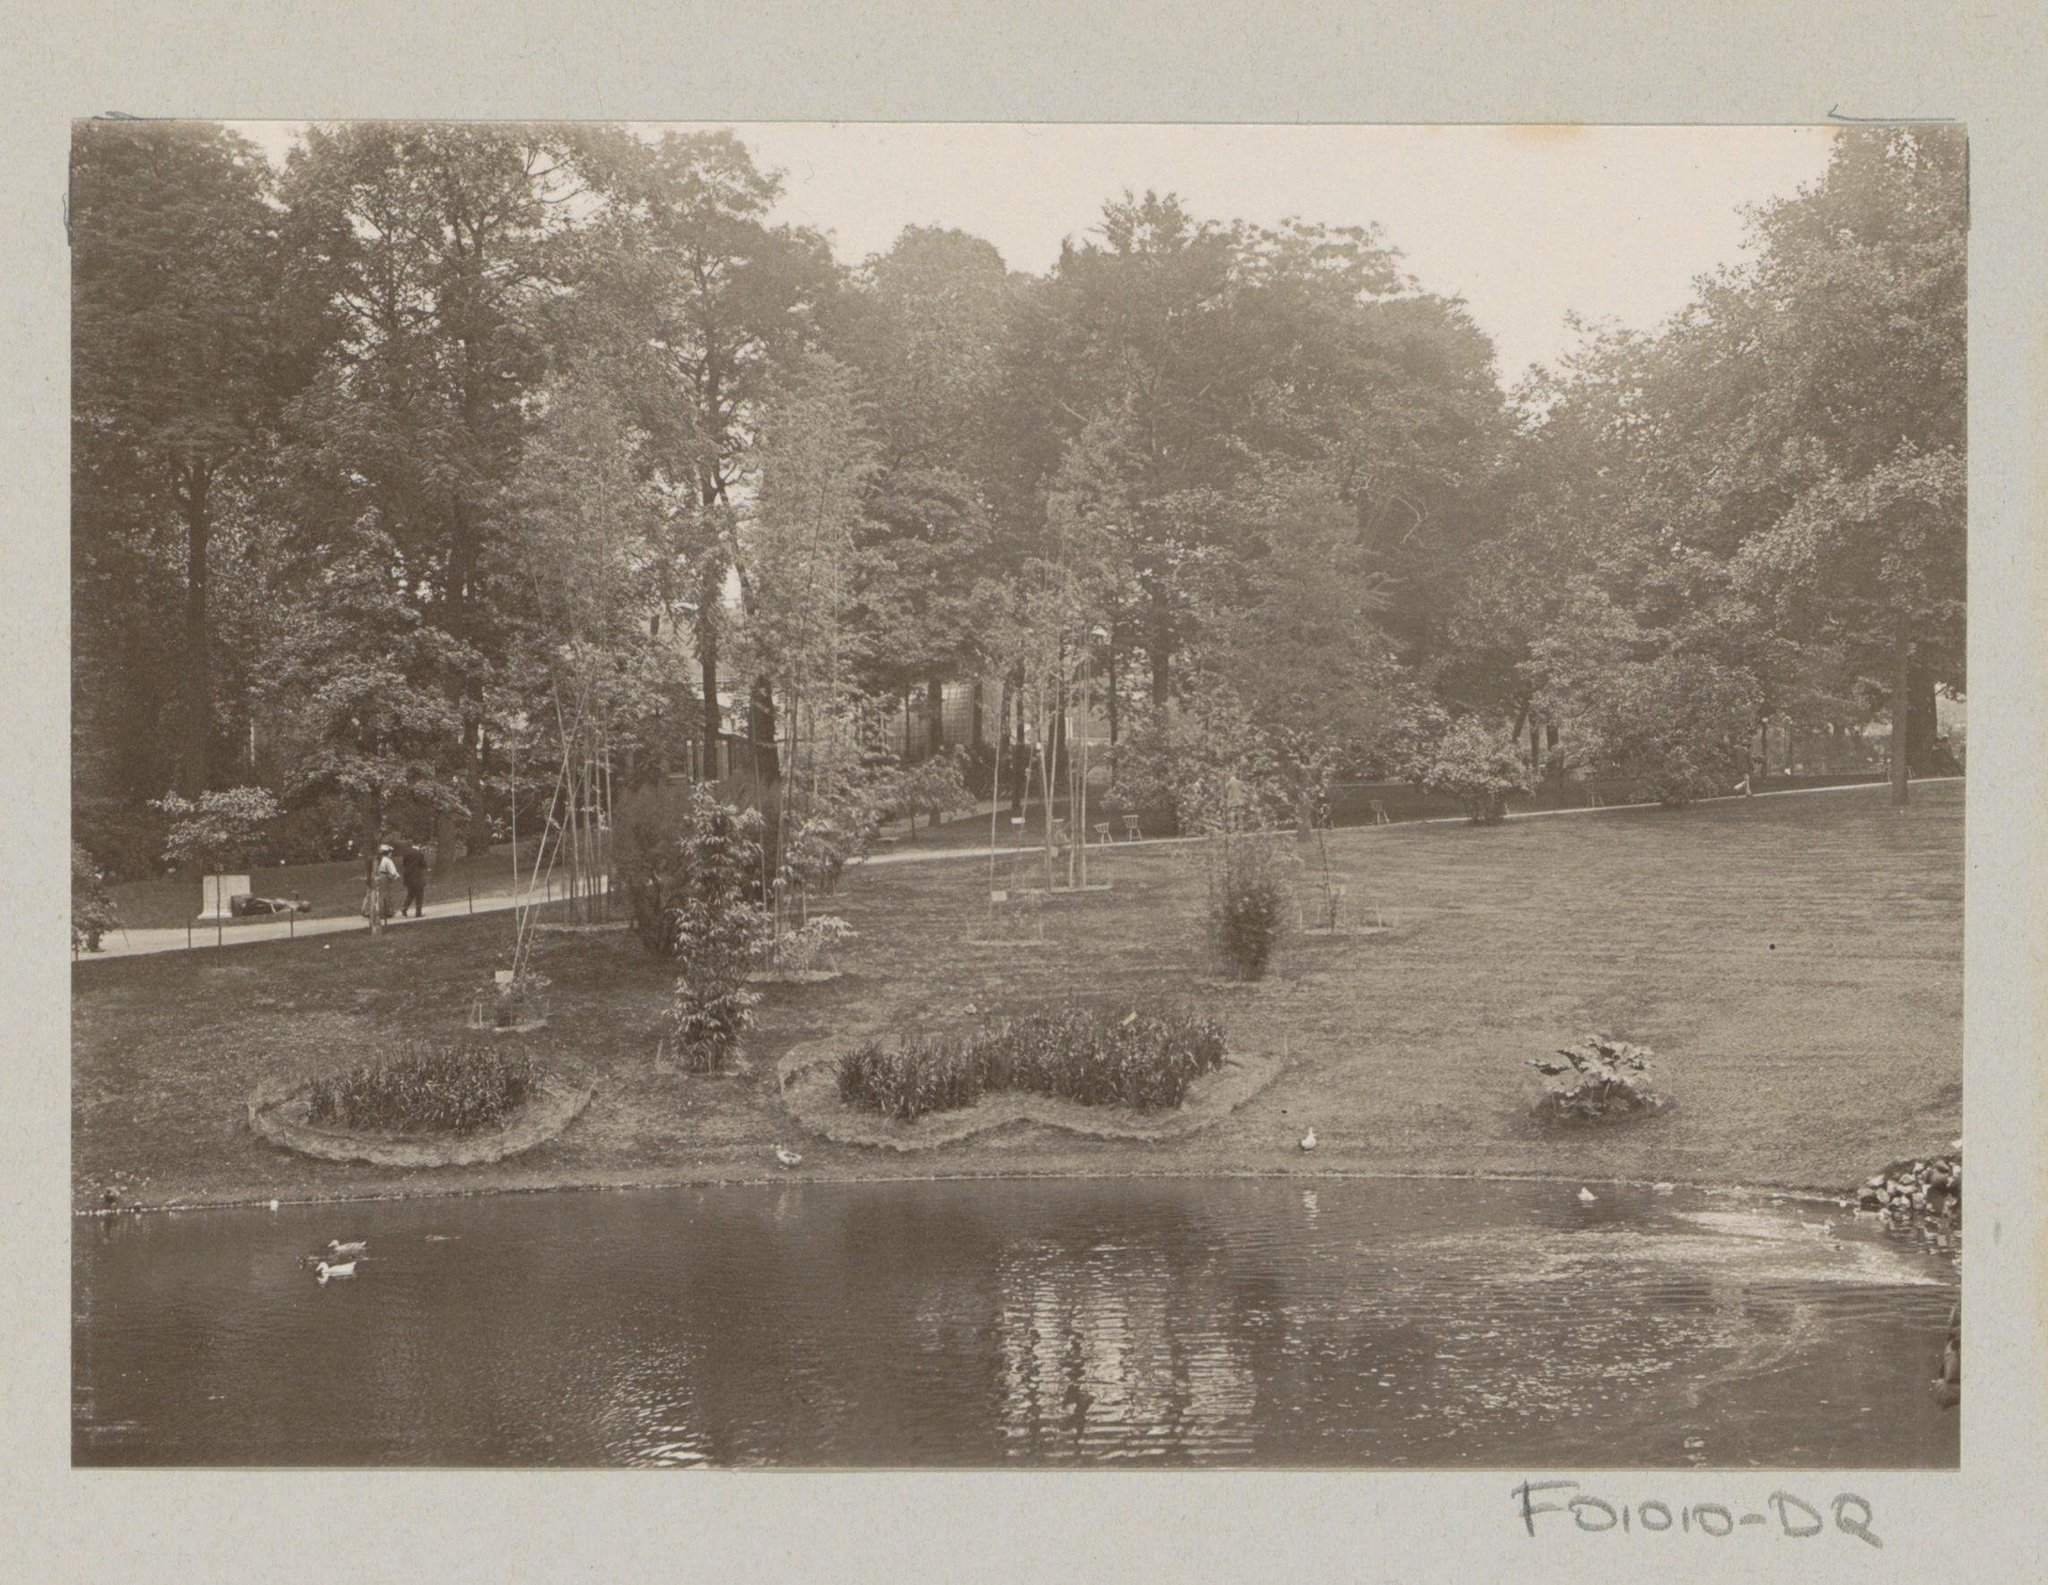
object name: photograph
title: Vijver in een park, vermoedelijk te Laken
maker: Anonymous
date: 1900-1910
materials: photographic support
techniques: matte daylight collodion silver print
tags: pond, public gardens, park, laeken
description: Onderdeel van Familiealbum met onder meer foto's van Wijnhandel Kraaij & Co. Bordeaux-Amsterdam.